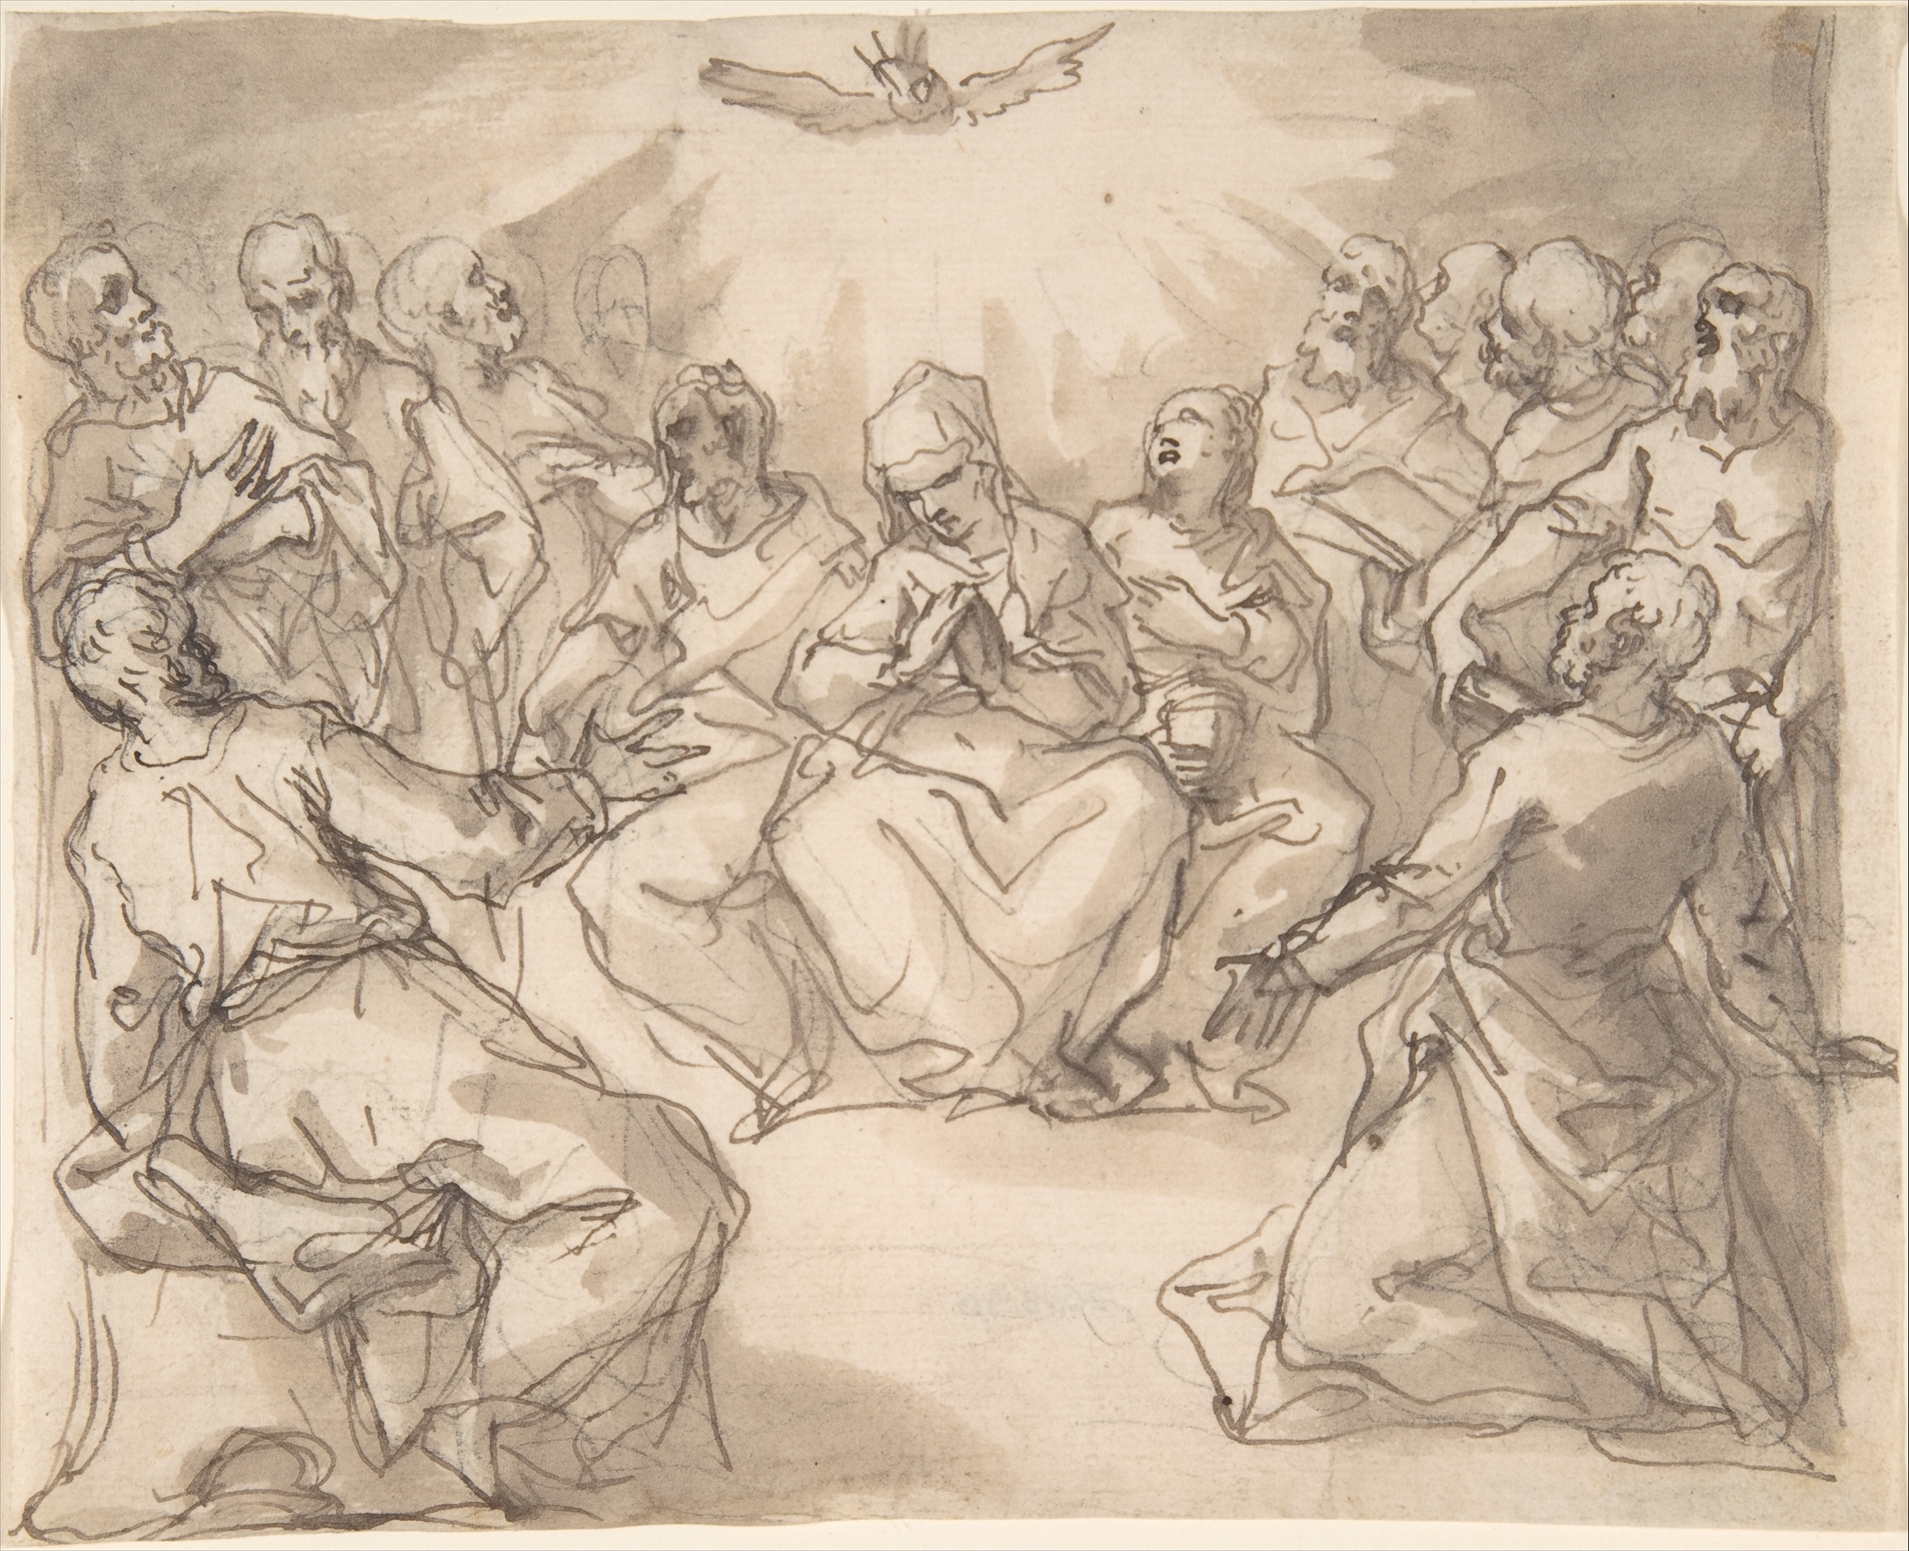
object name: drawing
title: The Descent of the Holy Ghost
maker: hans rottenhammer i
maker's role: artist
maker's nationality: german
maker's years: 1564-1625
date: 1567-1633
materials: graphite, ink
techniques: pen, wash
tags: human figures,birds